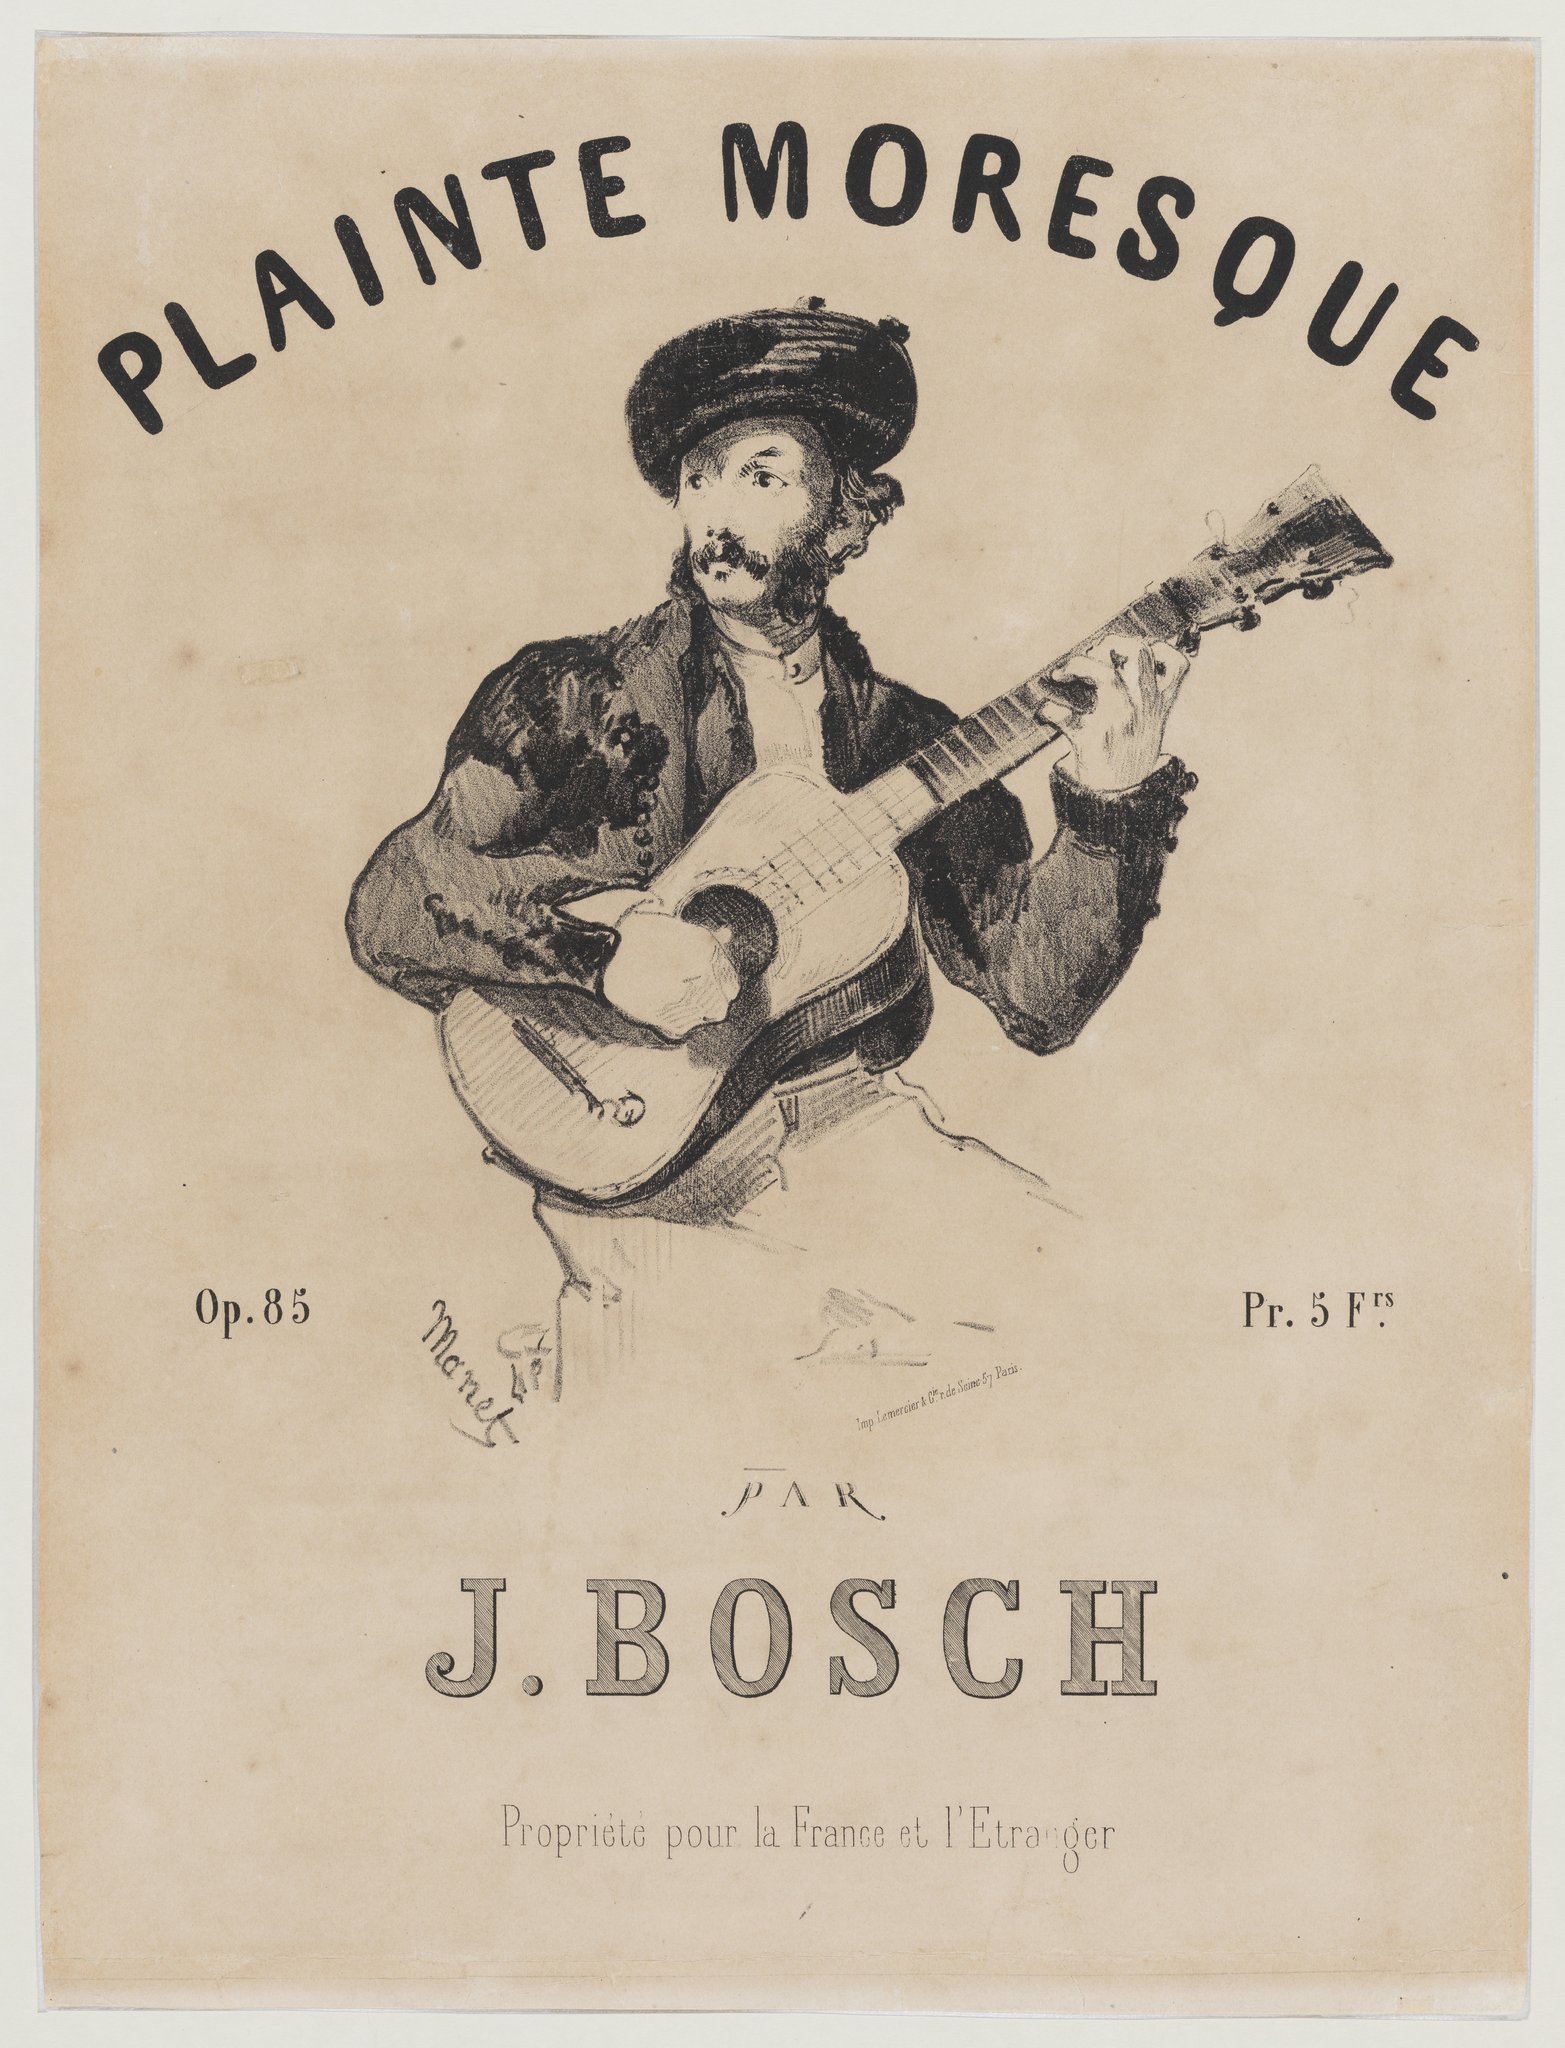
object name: print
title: Plainte Moresque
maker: édouard manet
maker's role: artist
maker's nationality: french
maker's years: 1832-1883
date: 1866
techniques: lithograph